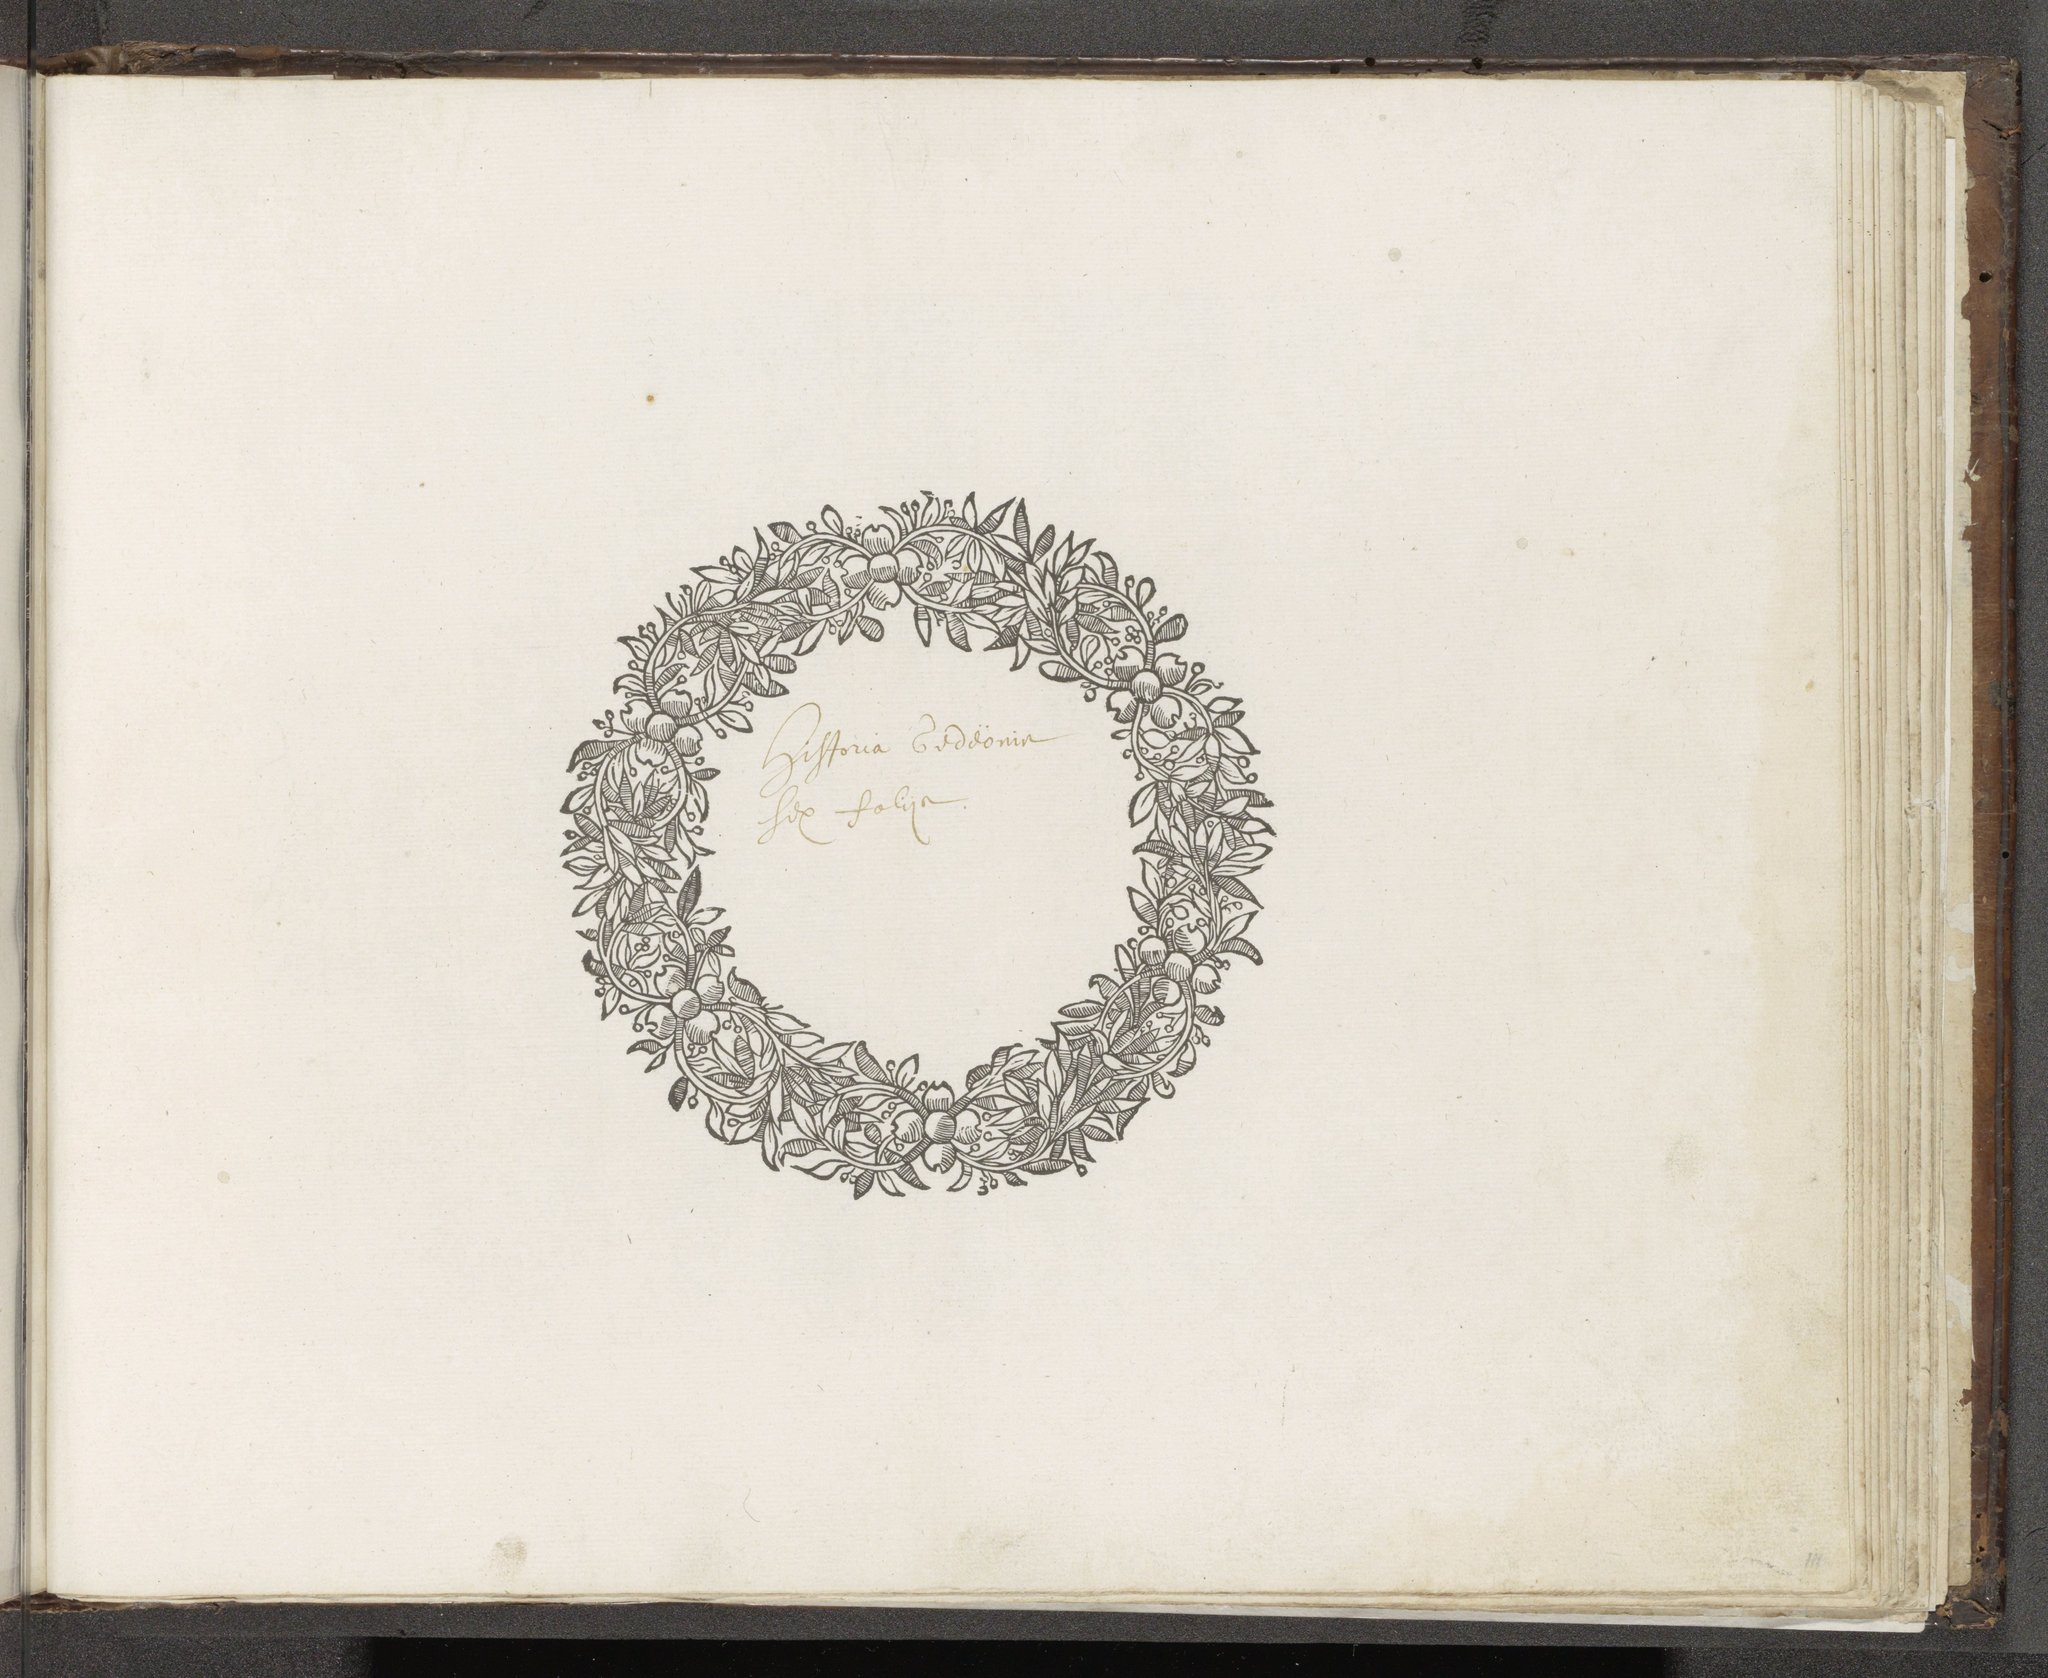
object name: album leaf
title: Historia Giddöni Sive folijn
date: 1579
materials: paper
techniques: woodcut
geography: antwerp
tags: garland, wreath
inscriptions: inscription: ‘Historia Giddöni Sive folijn’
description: Ornamentele bloemenkrans met in het midden een handgeschreven titel. Prent maakt deel uit van een album.